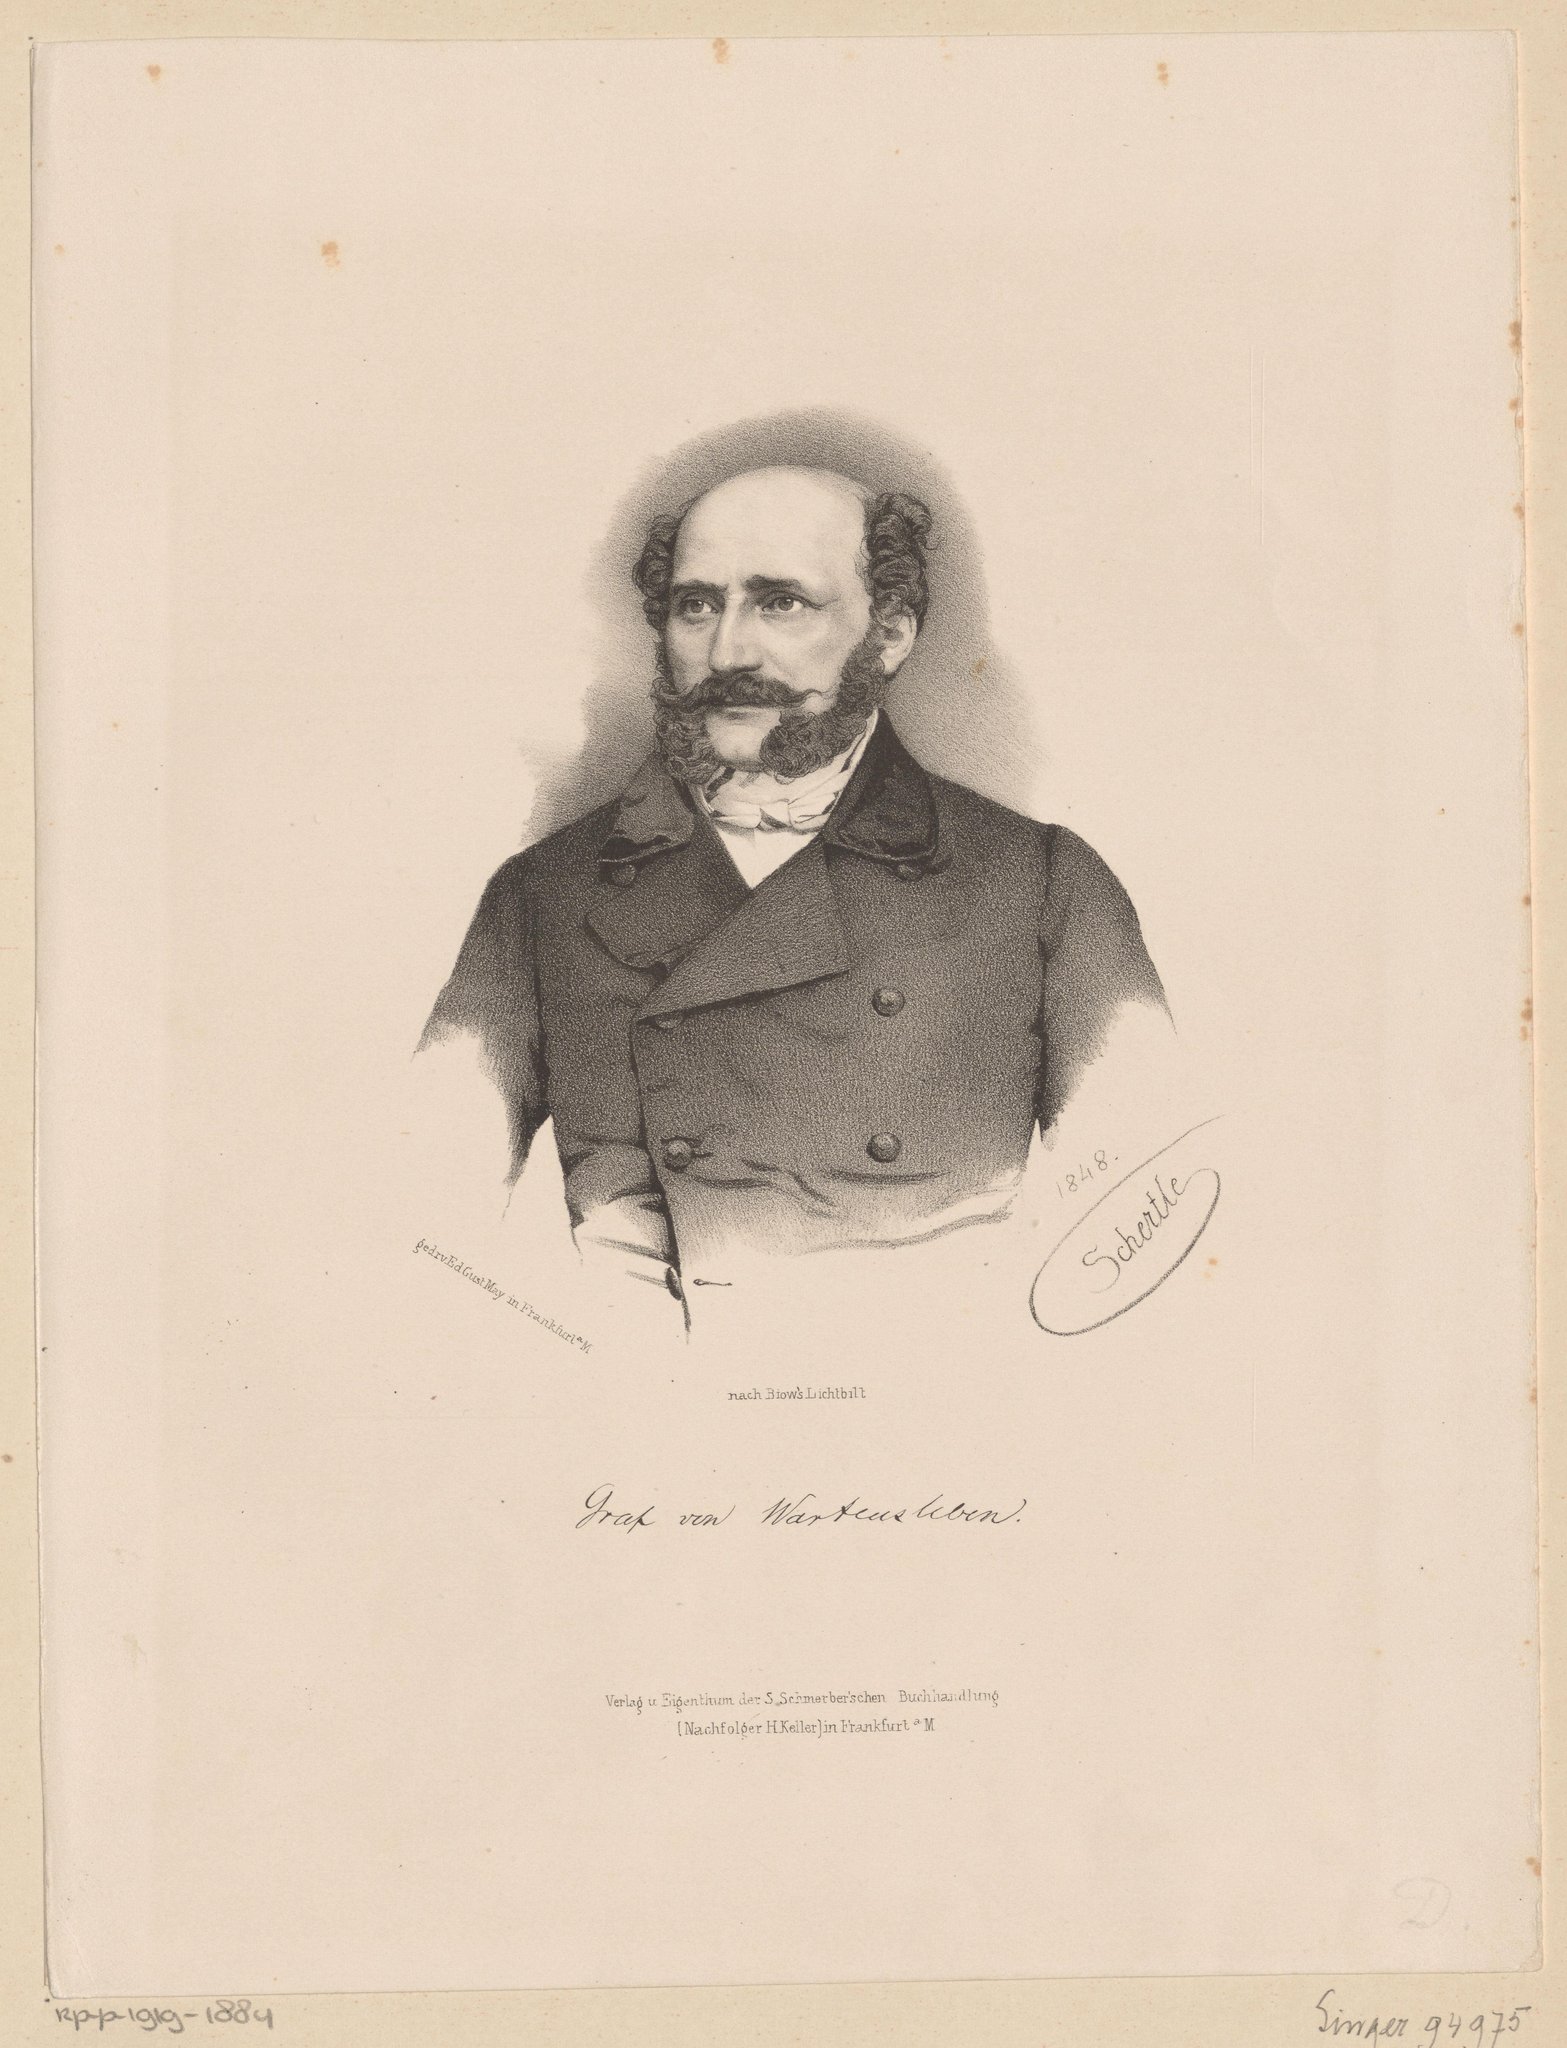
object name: print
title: Portretten van Duitse mannen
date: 1848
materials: paper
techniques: lithograph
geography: frankfurt am main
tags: politician, historical persons, politician, e.g. party leader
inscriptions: collector's mark: Lugt 2228